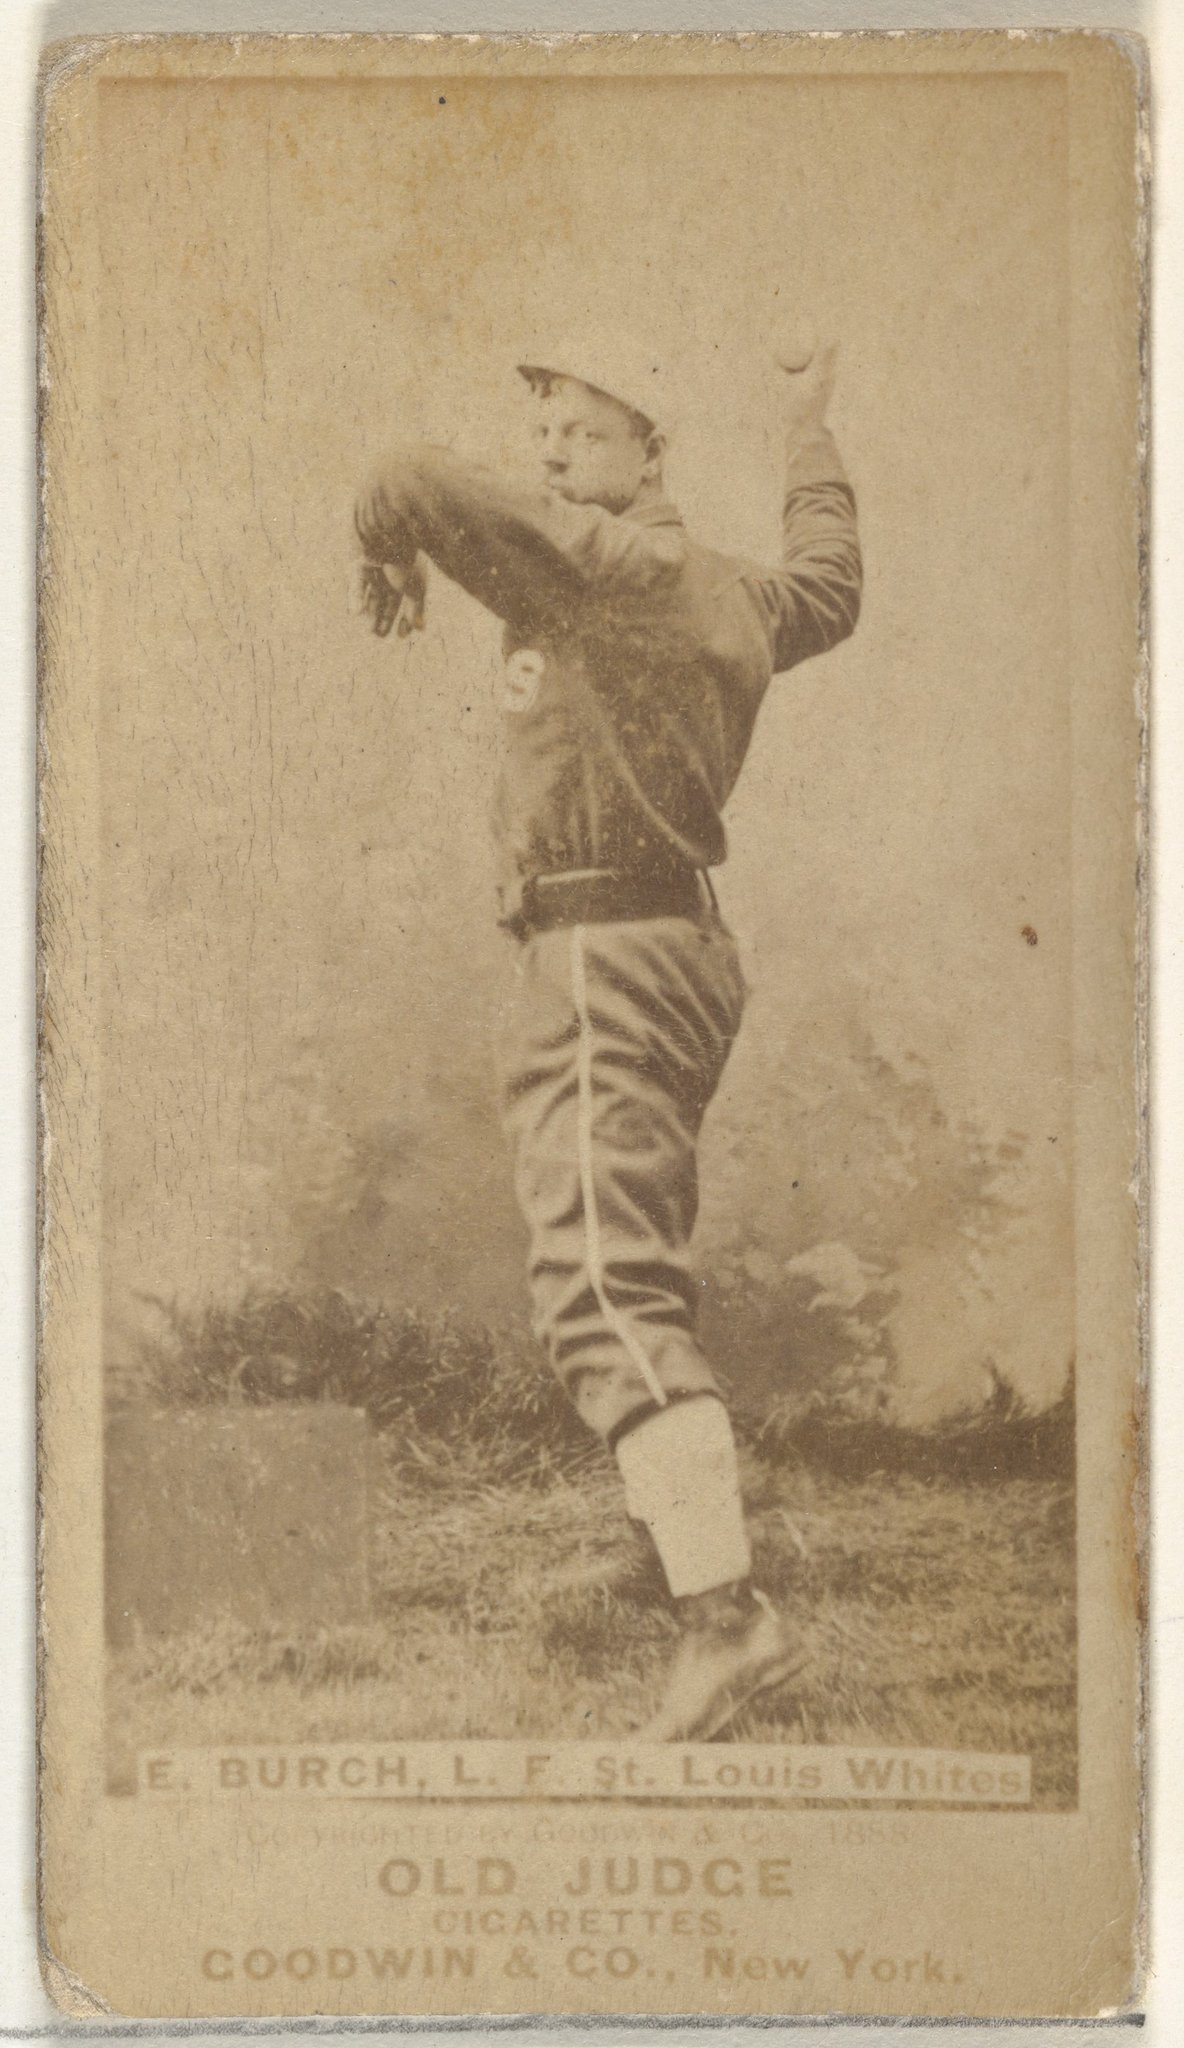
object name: baseball card, photograph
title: Burch, Left Field, St. Louis Whites, from the Old Judge series (N172) for Old Judge Cigarettes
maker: goodwin & company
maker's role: publisher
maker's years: 1850-1950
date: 1888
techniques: albumen silver print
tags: men,portraits,baseball,athletes